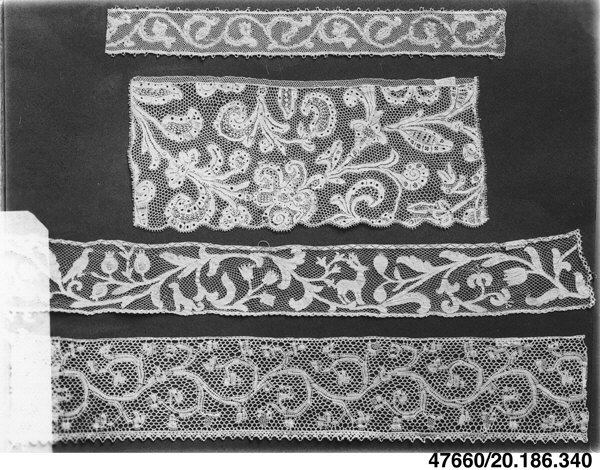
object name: edging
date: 1701-1800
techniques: lace